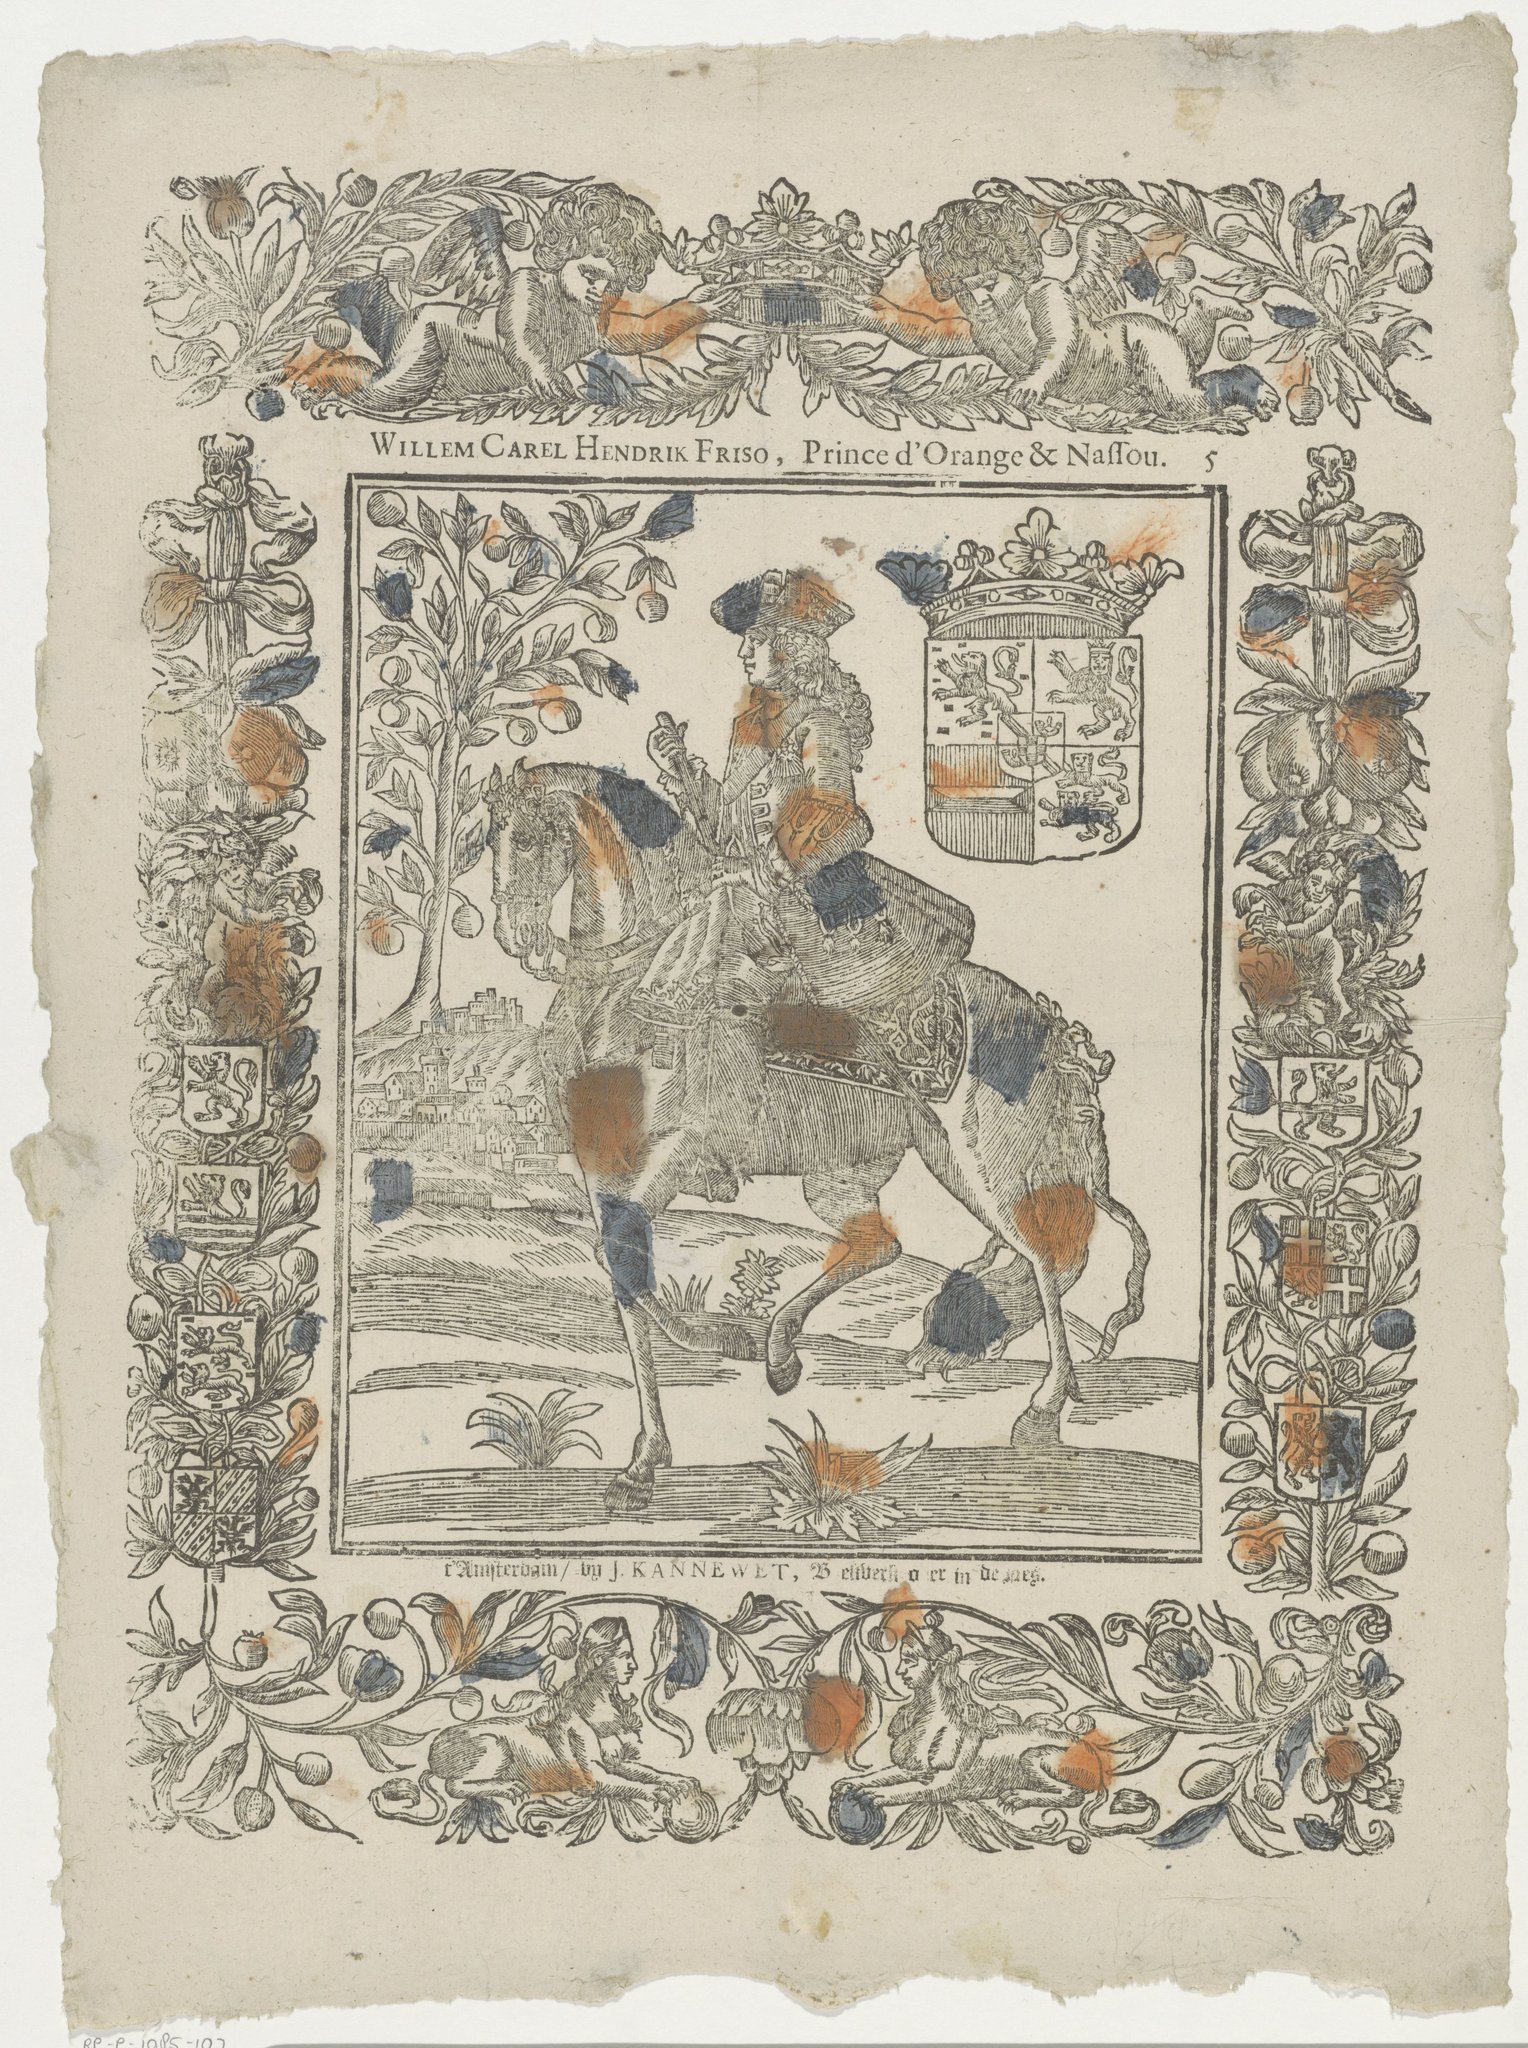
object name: print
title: Willem Carel Hendrik Friso, Prince d'Orange & Nassou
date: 1725-1780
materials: paper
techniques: colour, letterpress printing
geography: amsterdam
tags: the hague, willem iv (prins van oranje-nassau), equestrian state-portrait, trees, floral interlace ~ ornament, armorial bearing, heraldry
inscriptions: collector's mark: Lugt 2760, collector's mark: Lugt 2760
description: Portret van Willem IV te paard in een landschap met links een boom en rechts een wapenschild. De voorstelling is gevat in een sierlijst met ranken, vruchten, wapenschilden, putti en sfinxen. Genummerd rechtsboven: 5.